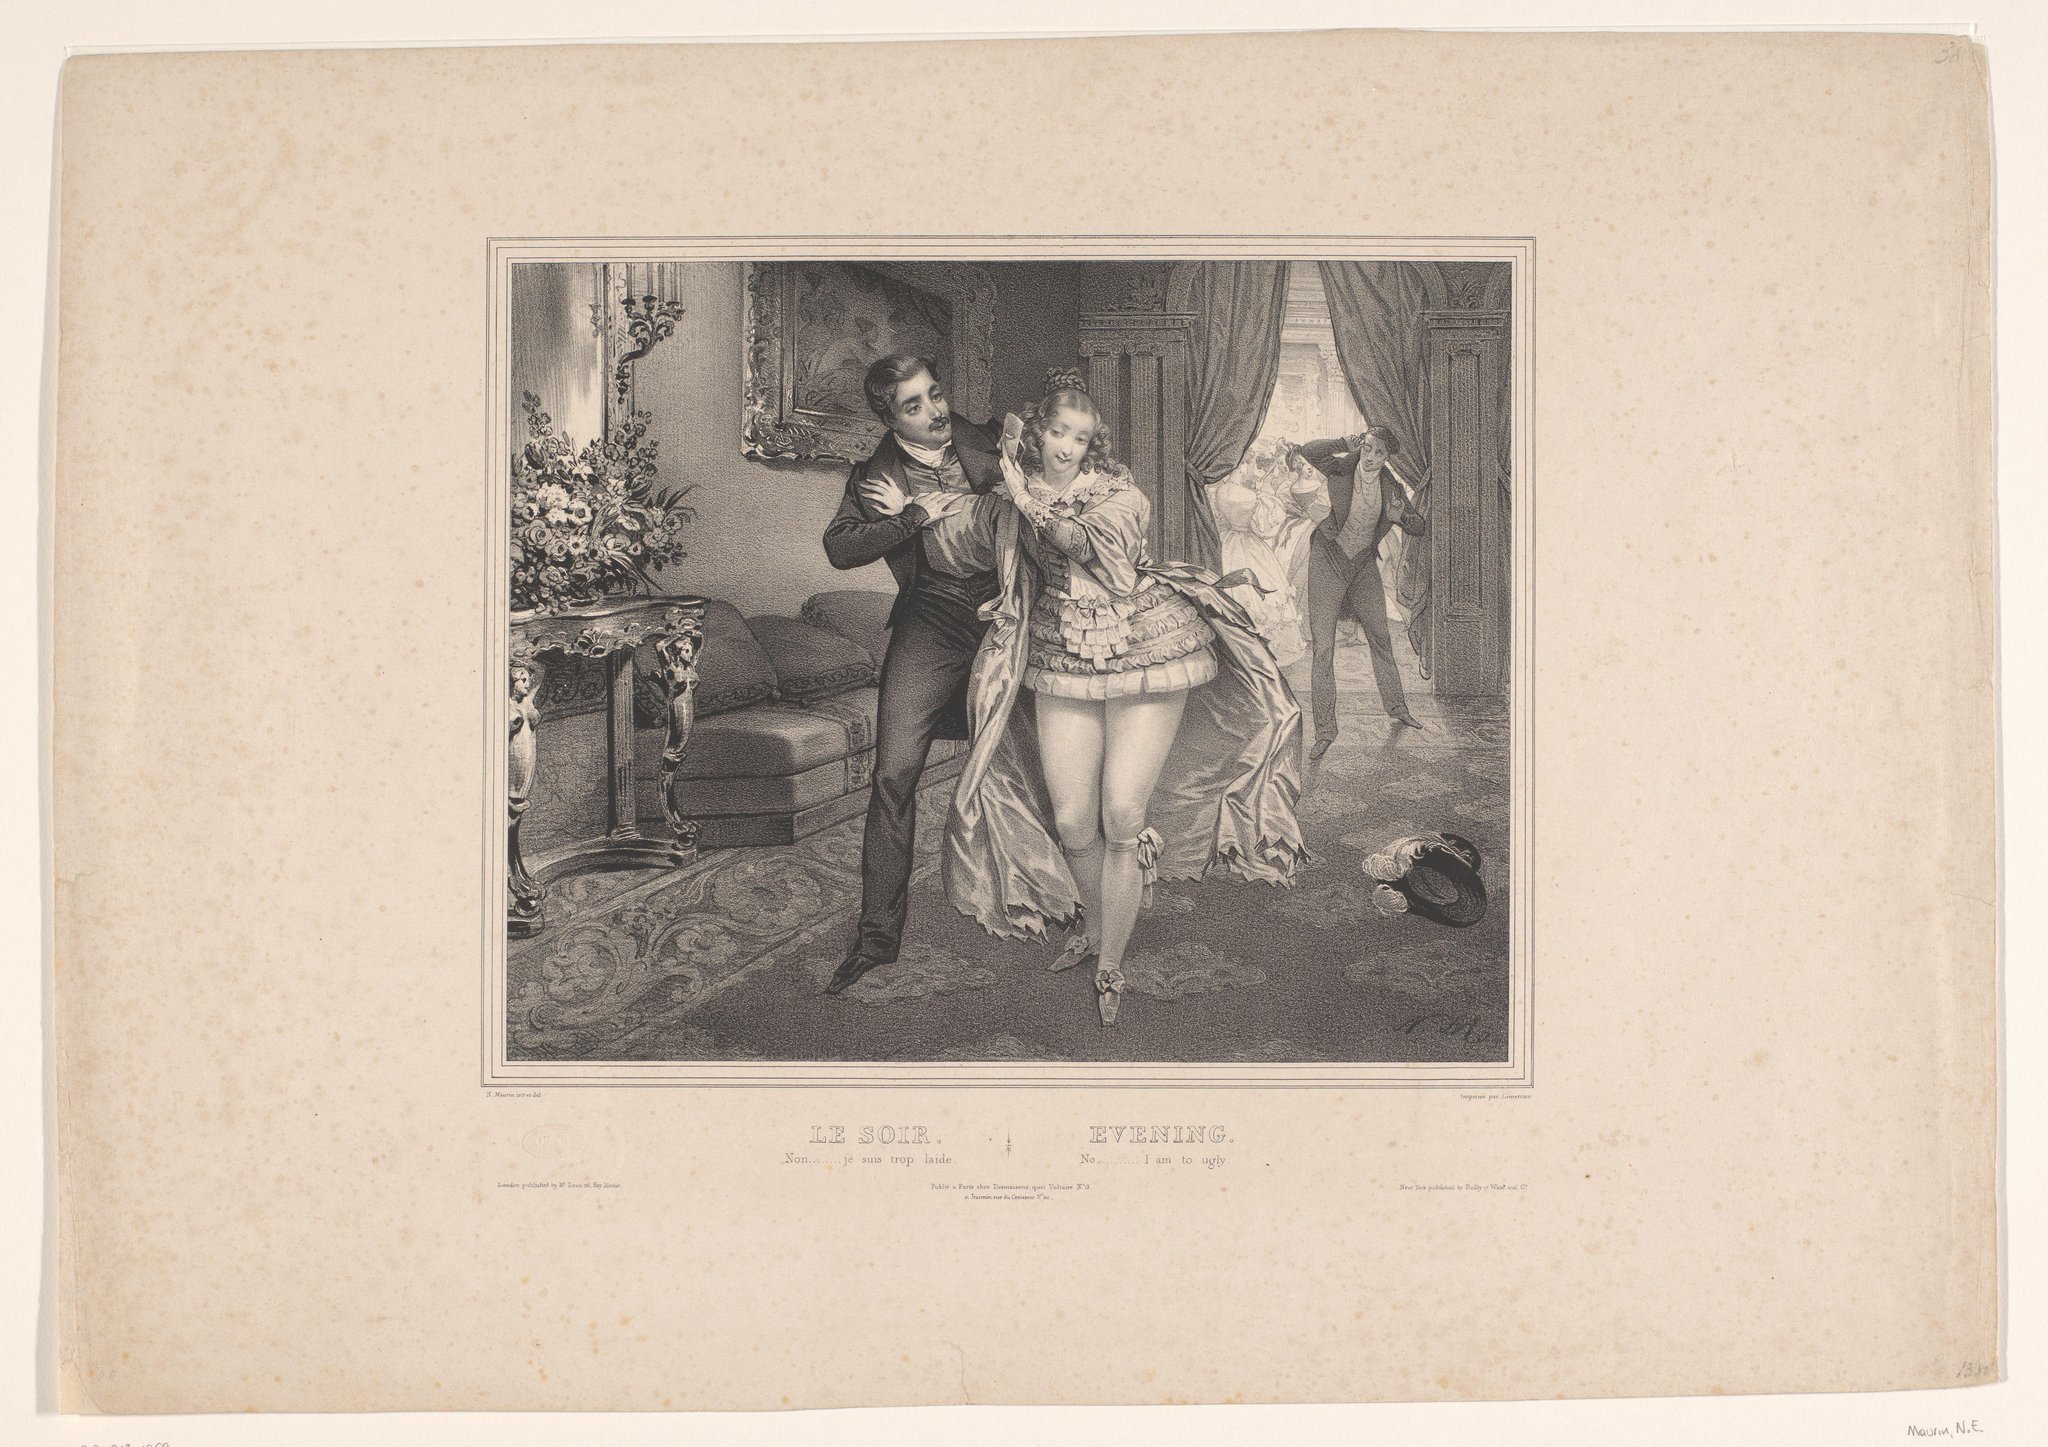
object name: print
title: Vrouw die een man afwijst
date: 1830-1837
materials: paper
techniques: lithograph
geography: paris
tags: refusal, evening, ball, formal dance, partially clothed - aa - female human figure, adult man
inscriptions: check stamp: Lugt 3987, check stamp: ‘ED’, collector's mark: Lugt 2228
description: In een kamer lopen een man en een half ontkleedde vrouw. De man probeert haar vast te pakken, maar de vrouw duwt hem weg terwijl ze een masker voorhoudt. Een derde figuur staat in de opening van een balzaal gevuld met dansende paren en kijkt naar het stel.